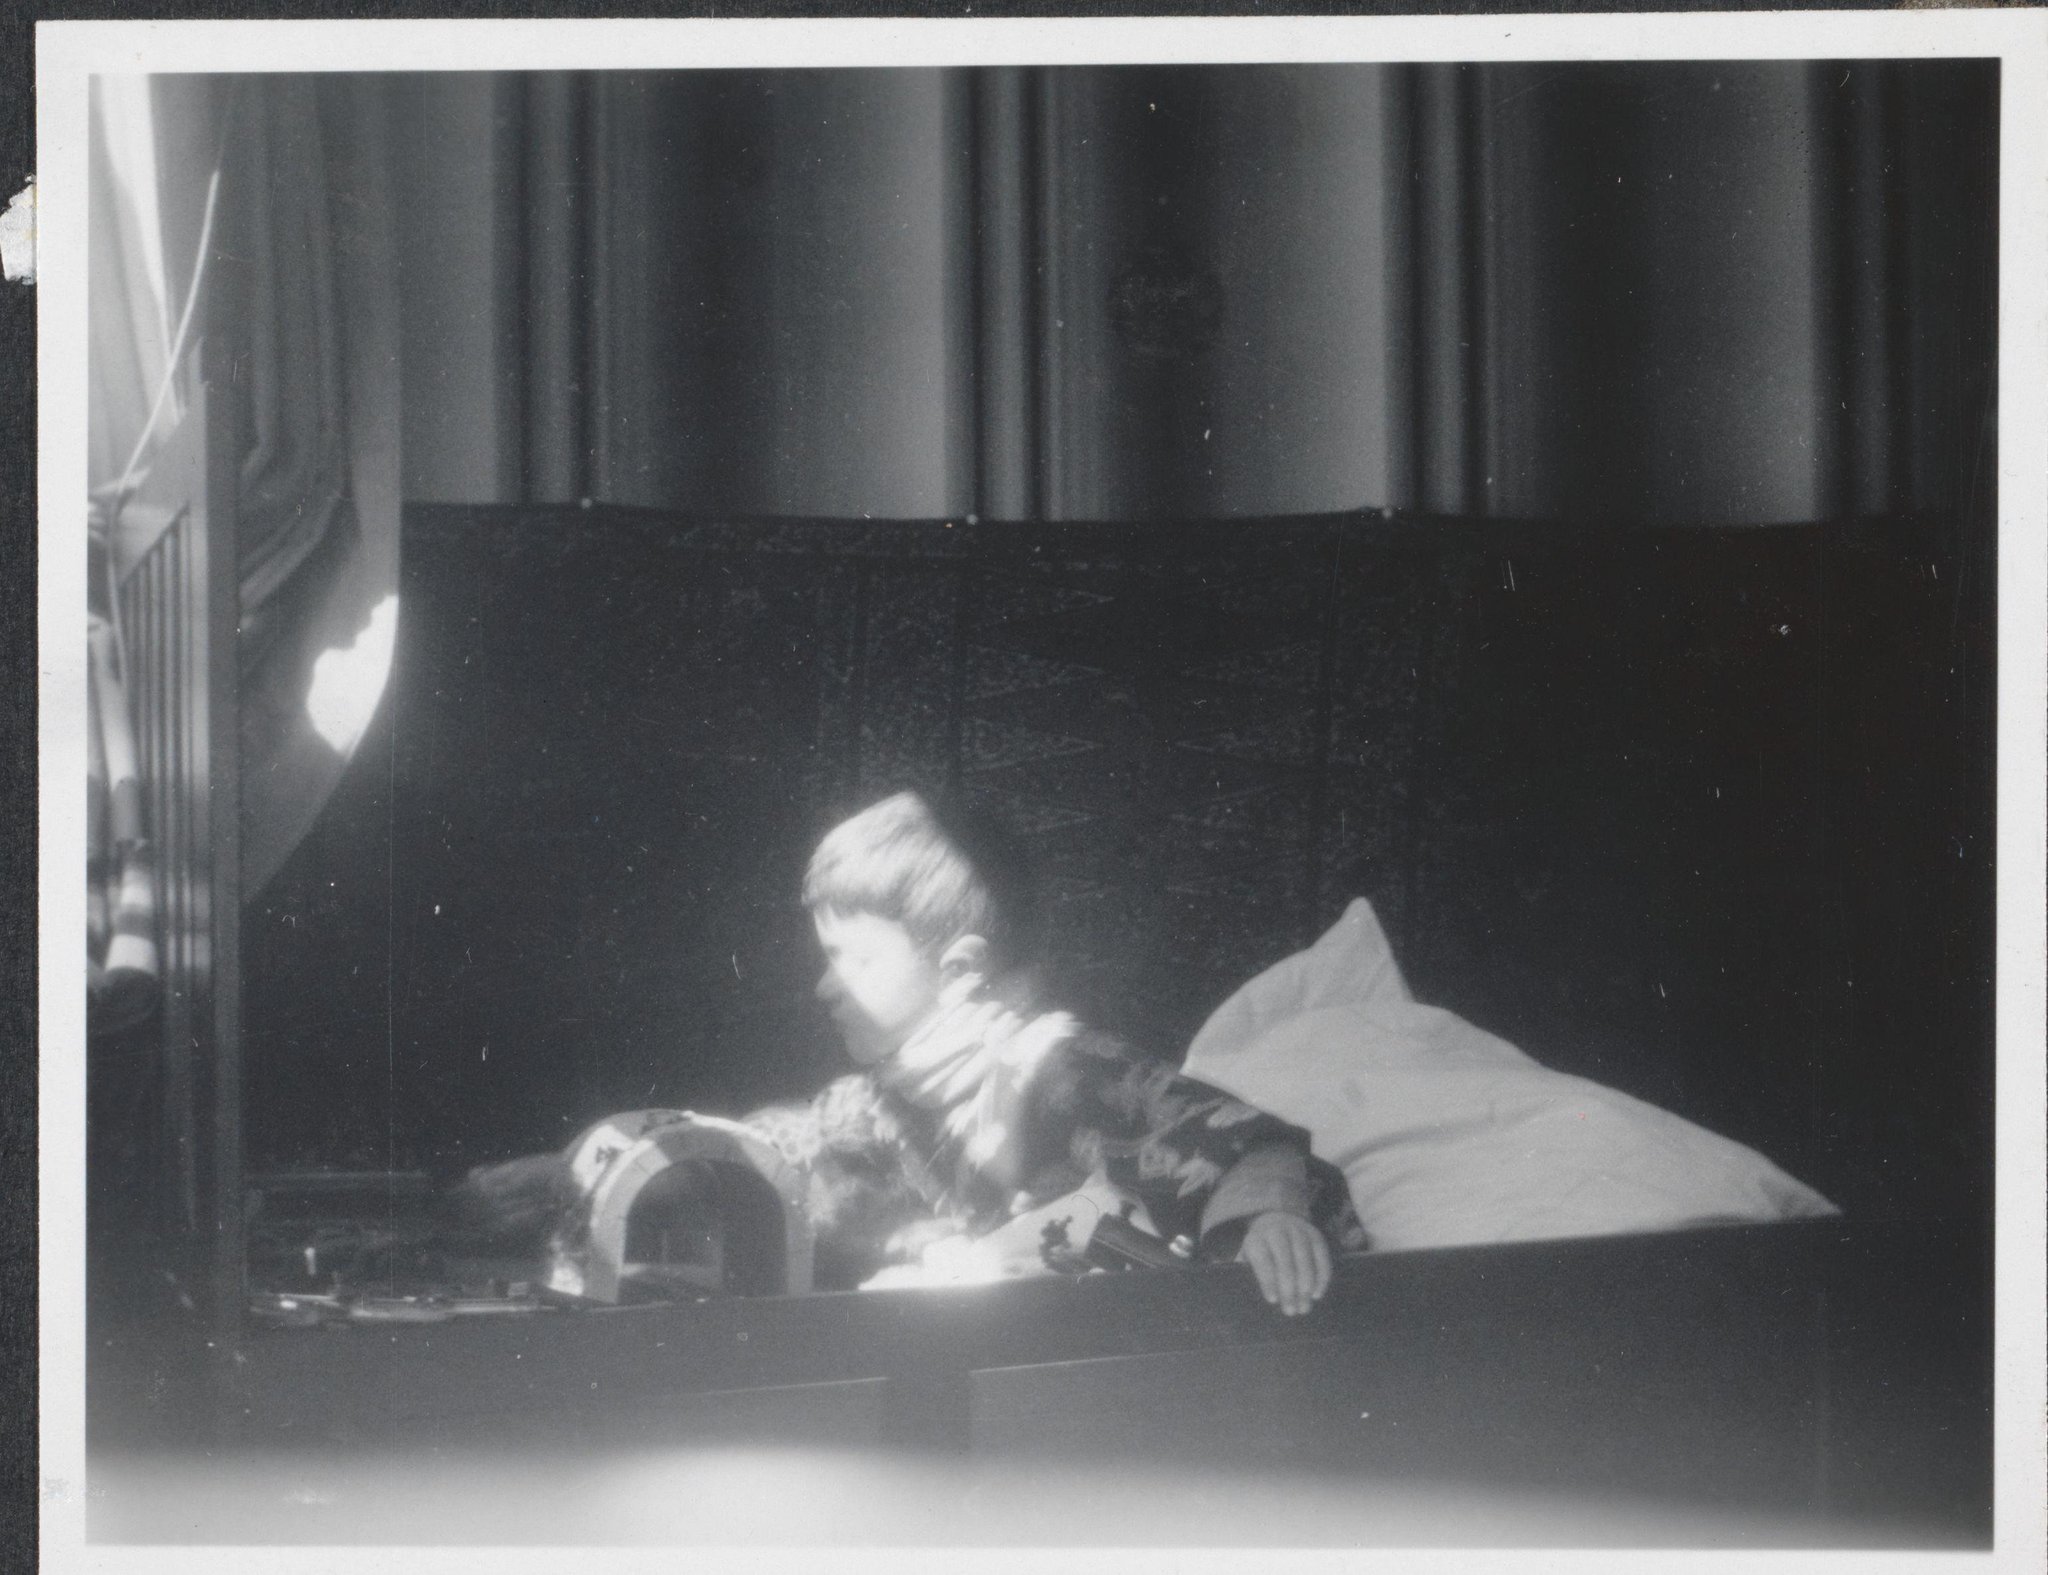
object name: photograph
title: Herbert Hondius in een kinderkimono in bed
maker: Anonymous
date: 1927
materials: photographic support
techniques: gelatin silver print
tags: sick-bed, child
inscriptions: inscription: ‘Herbert's operatie 28 mei 1927’